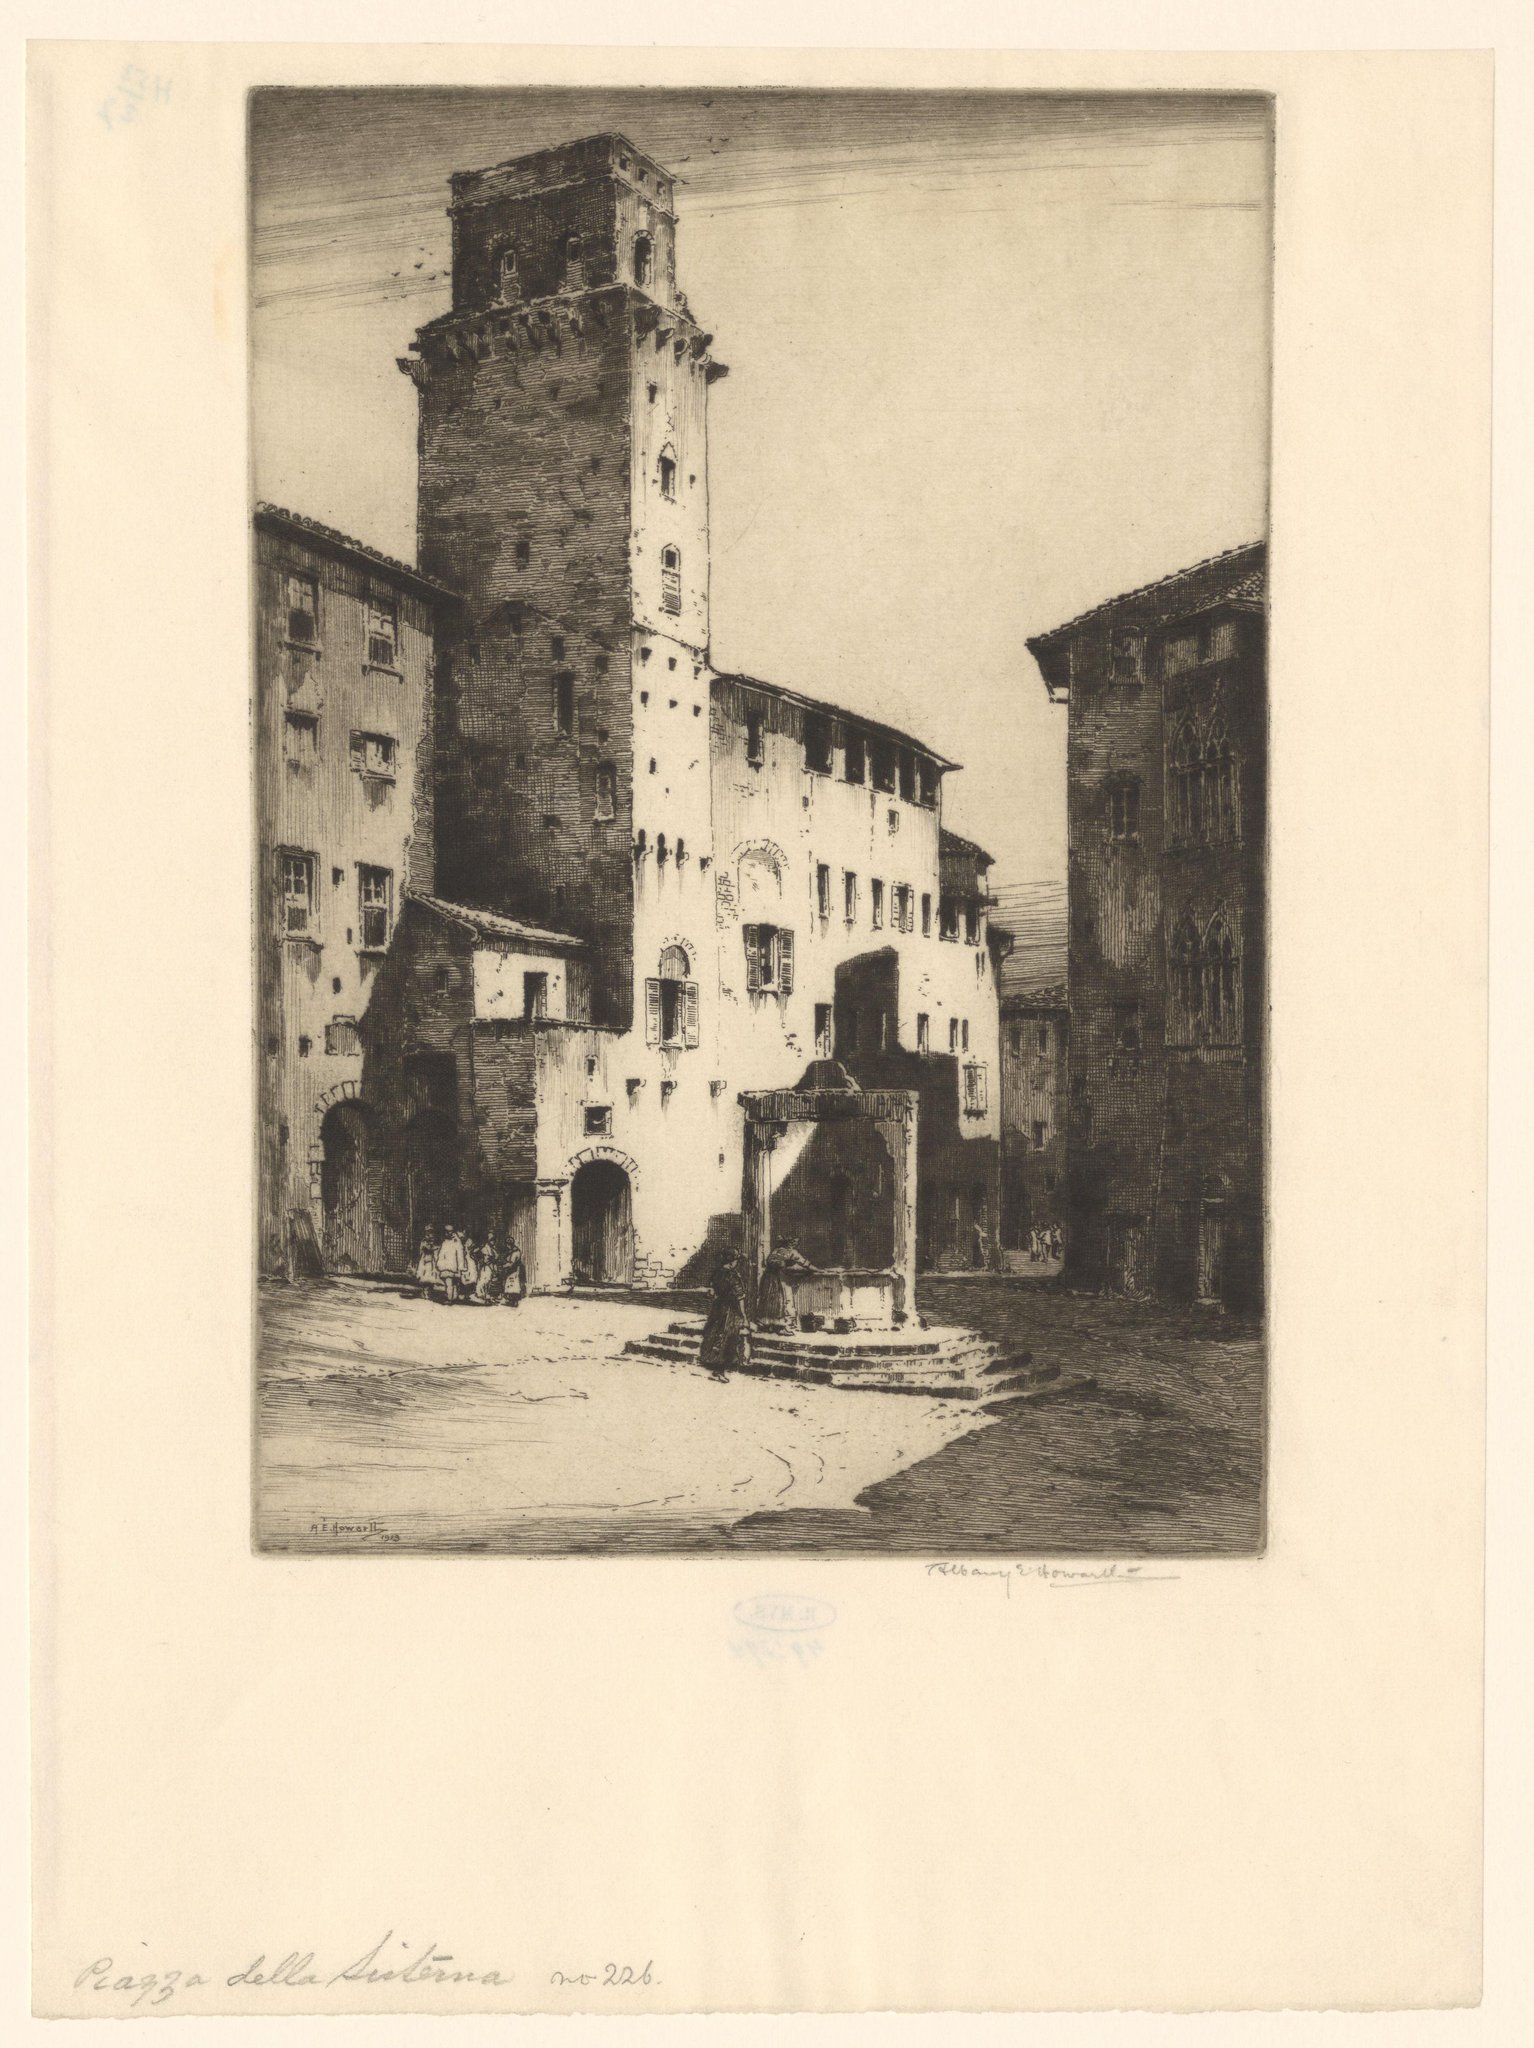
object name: print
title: Gezicht op het Piazza della Cisterna in San Gimignano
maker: albany e. howarth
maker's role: print maker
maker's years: 1872-1936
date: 1913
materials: paper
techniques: etching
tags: village square, place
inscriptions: annotation: ‘Piazza della Sisterna no. 226’, collector's mark: Lugt 2228